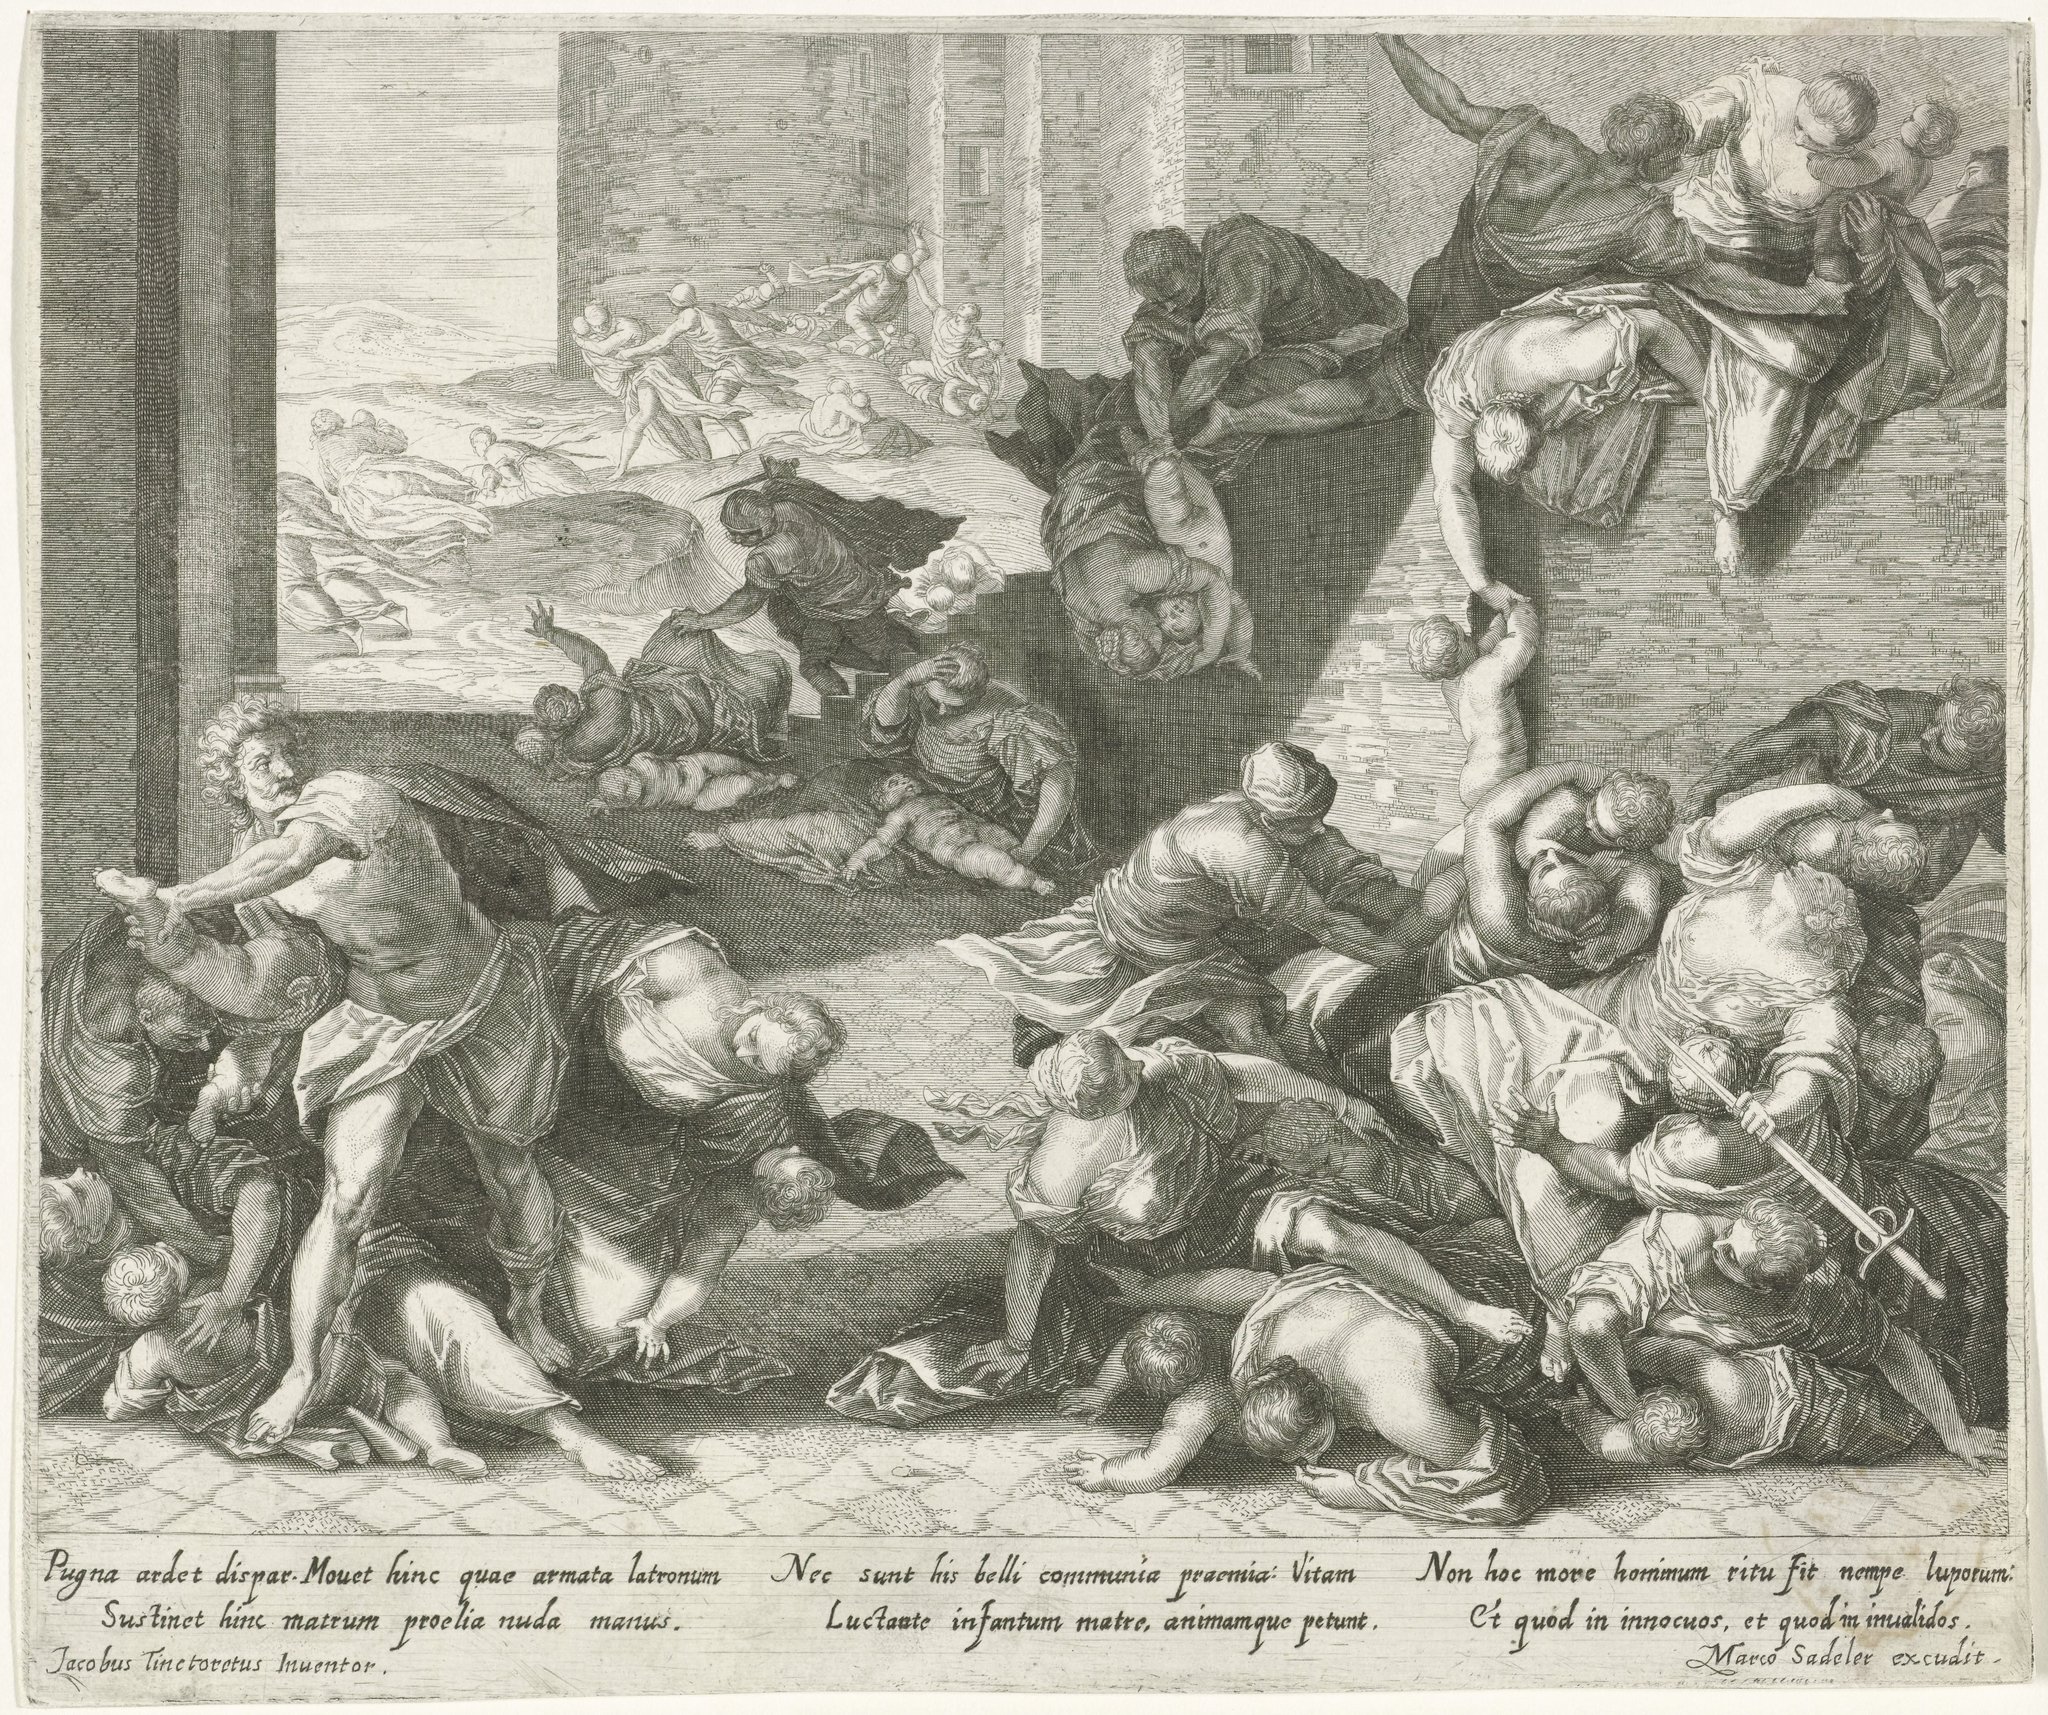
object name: print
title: Kindermoord te Betlehem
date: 1580-1679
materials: paper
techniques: engraving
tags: the massacre of the innocents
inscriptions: collector's mark: Lugt 240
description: In de straten van Betlehem proberen moeders hun kinderen te beschermen tegen de soldaten van Herodes. De soldaten hebben de opdracht gekregen alle jongens van twee jaar en jonger te vermoorden. De prent heeft een Latijns onderschrift met uitleg.